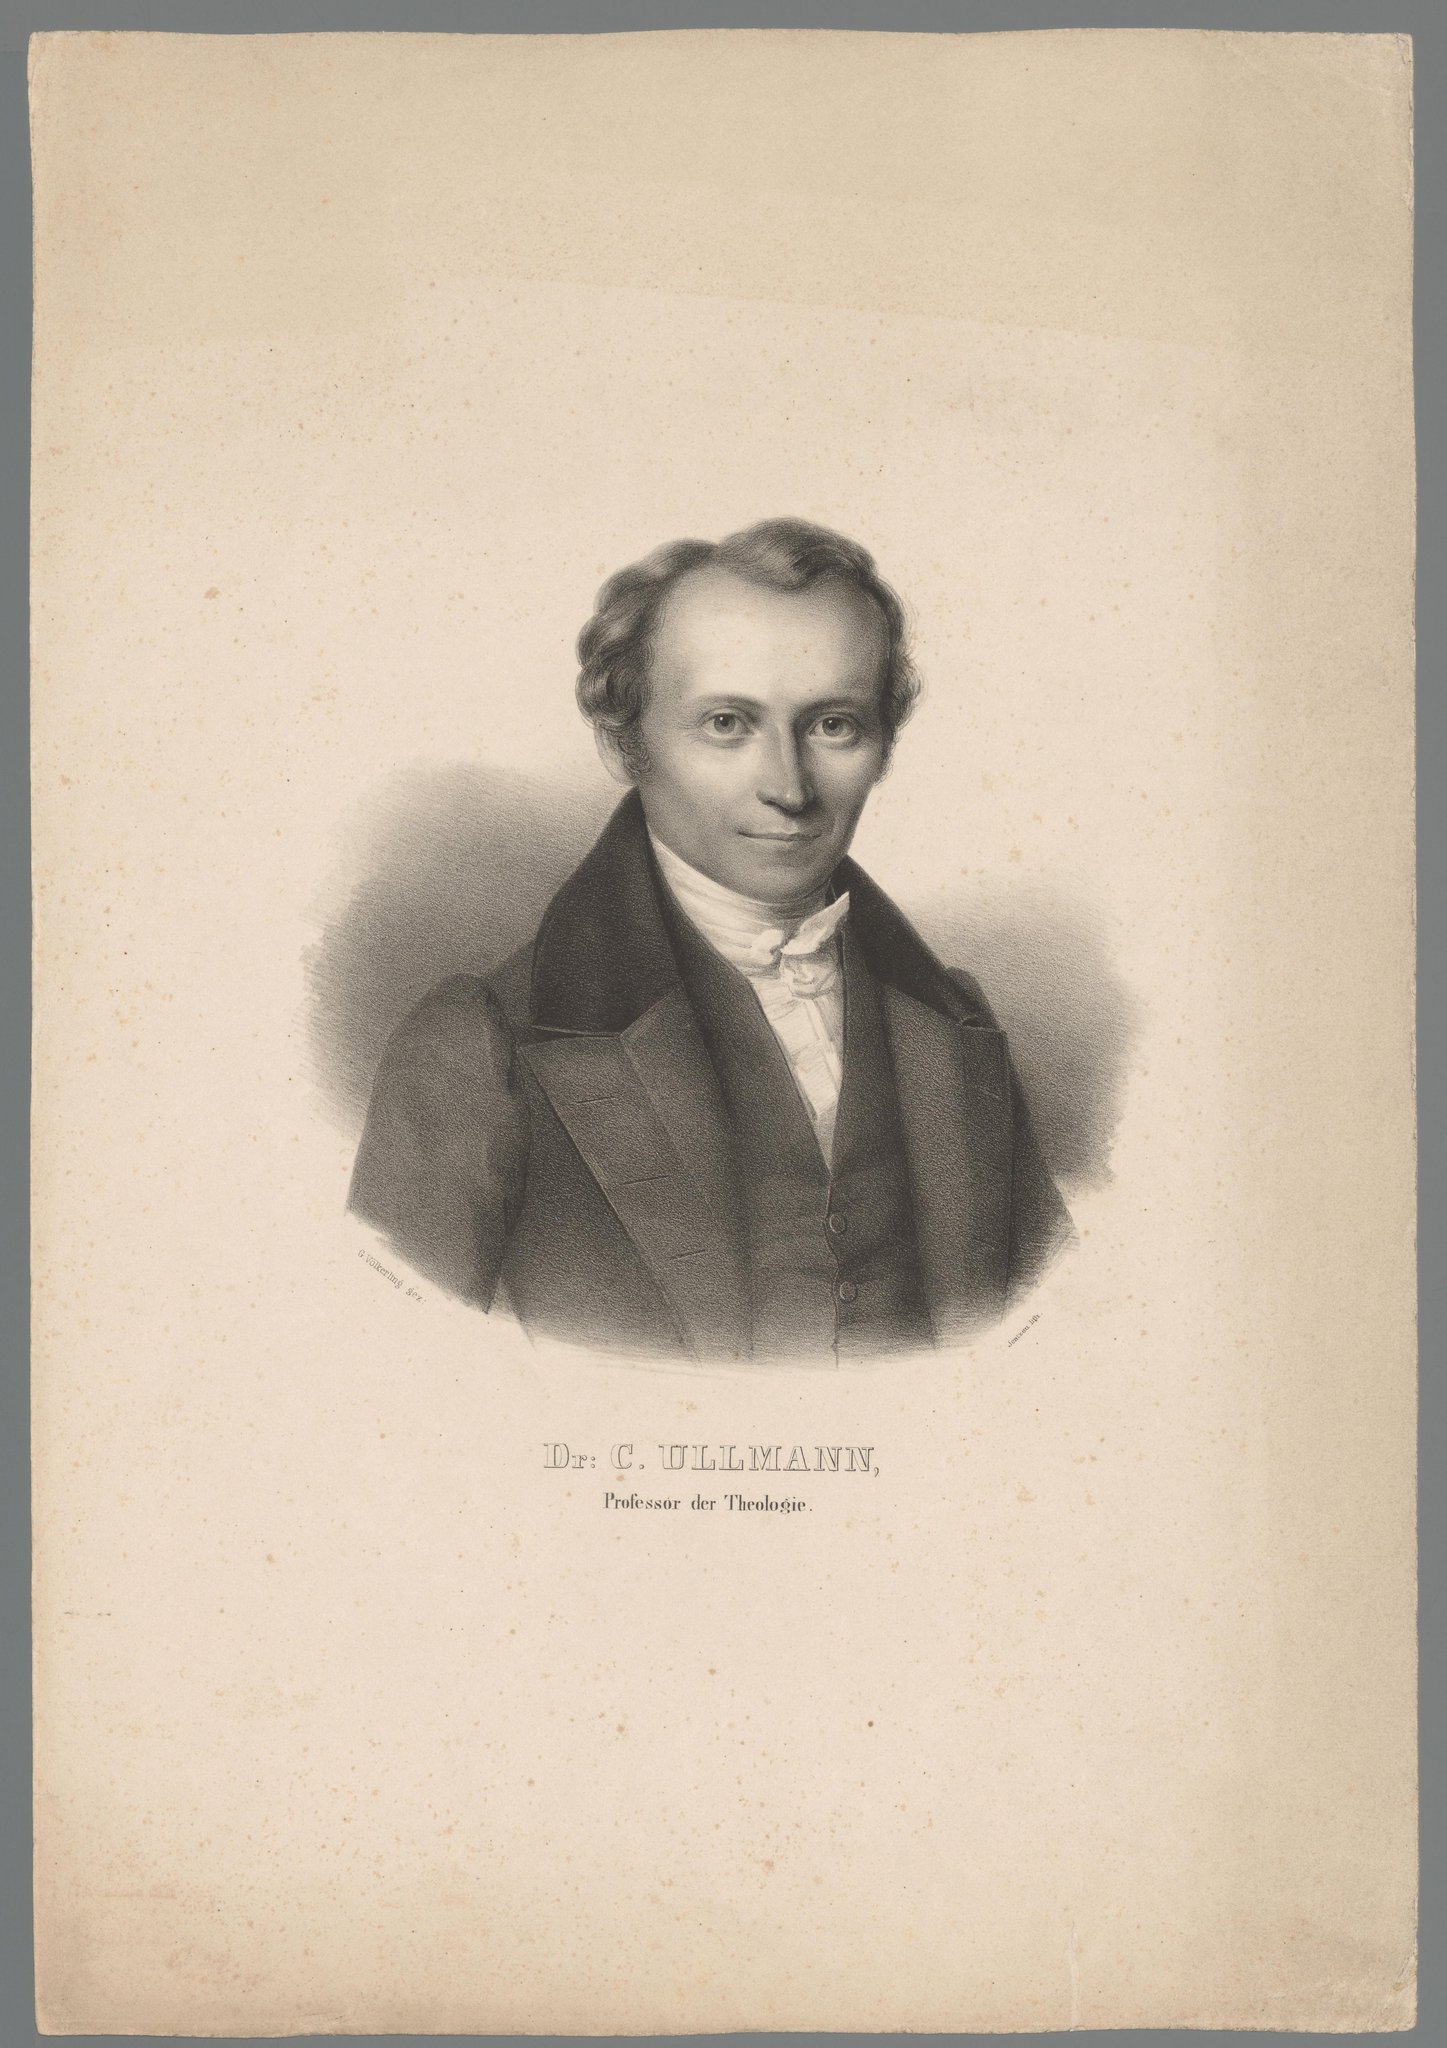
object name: print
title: Dr. C. Ullmann, Professor der Theologie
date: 1820-1875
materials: paper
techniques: lithograph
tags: adult man, historical persons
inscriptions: collector's mark: Lugt 2228